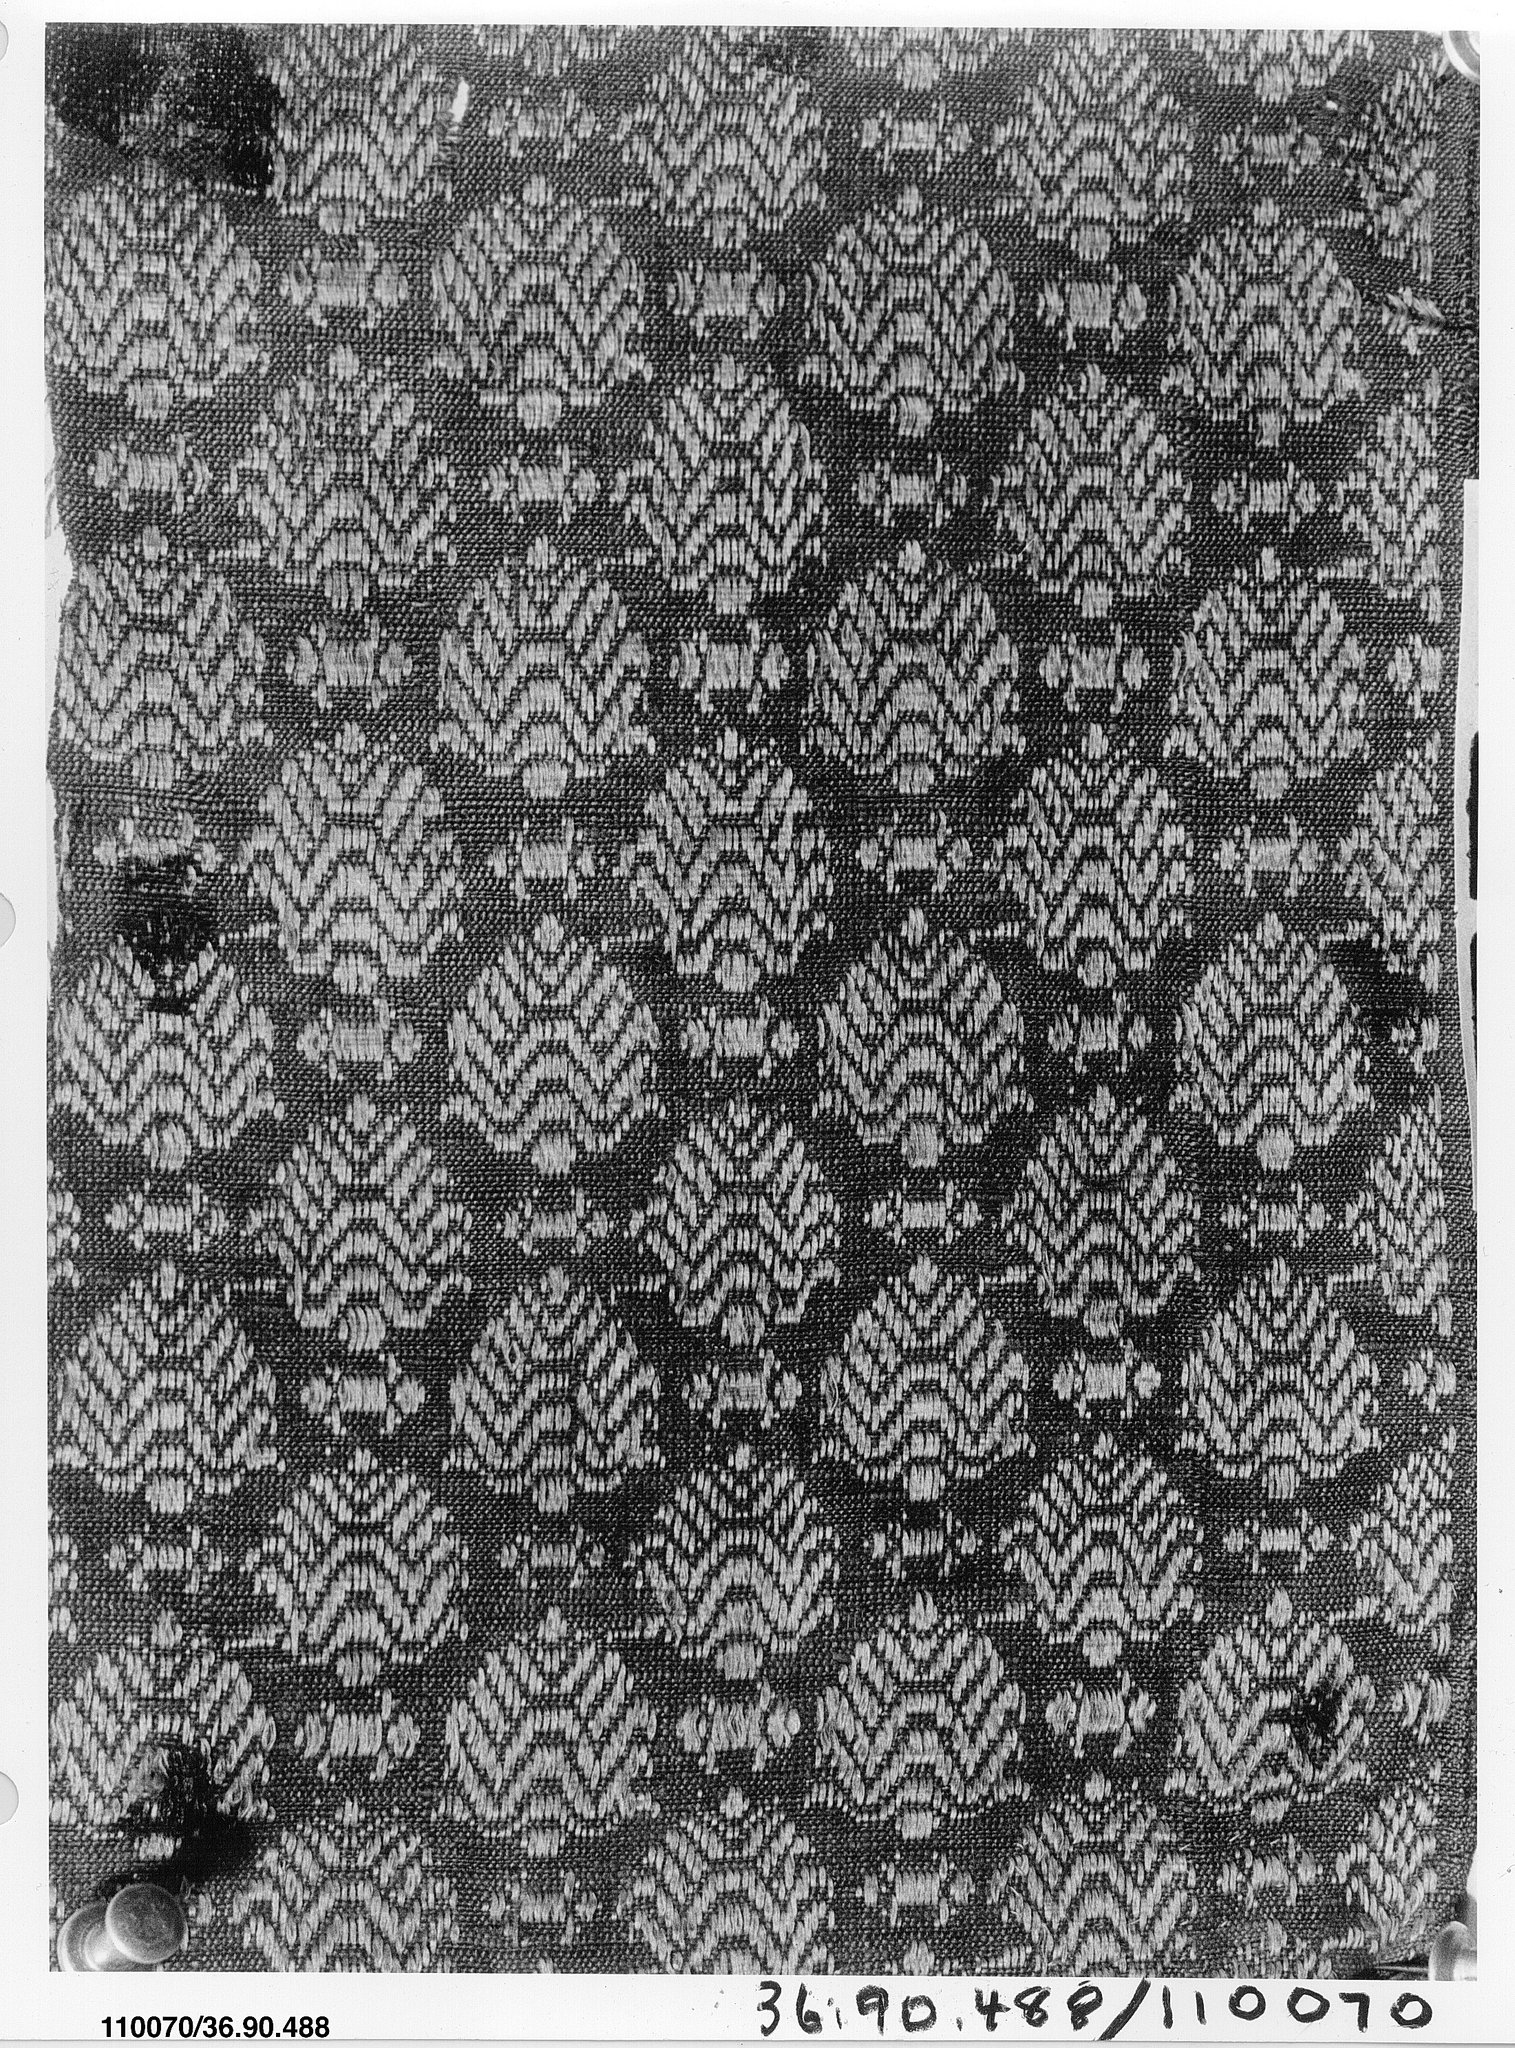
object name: piece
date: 1501-1700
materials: linen, silk